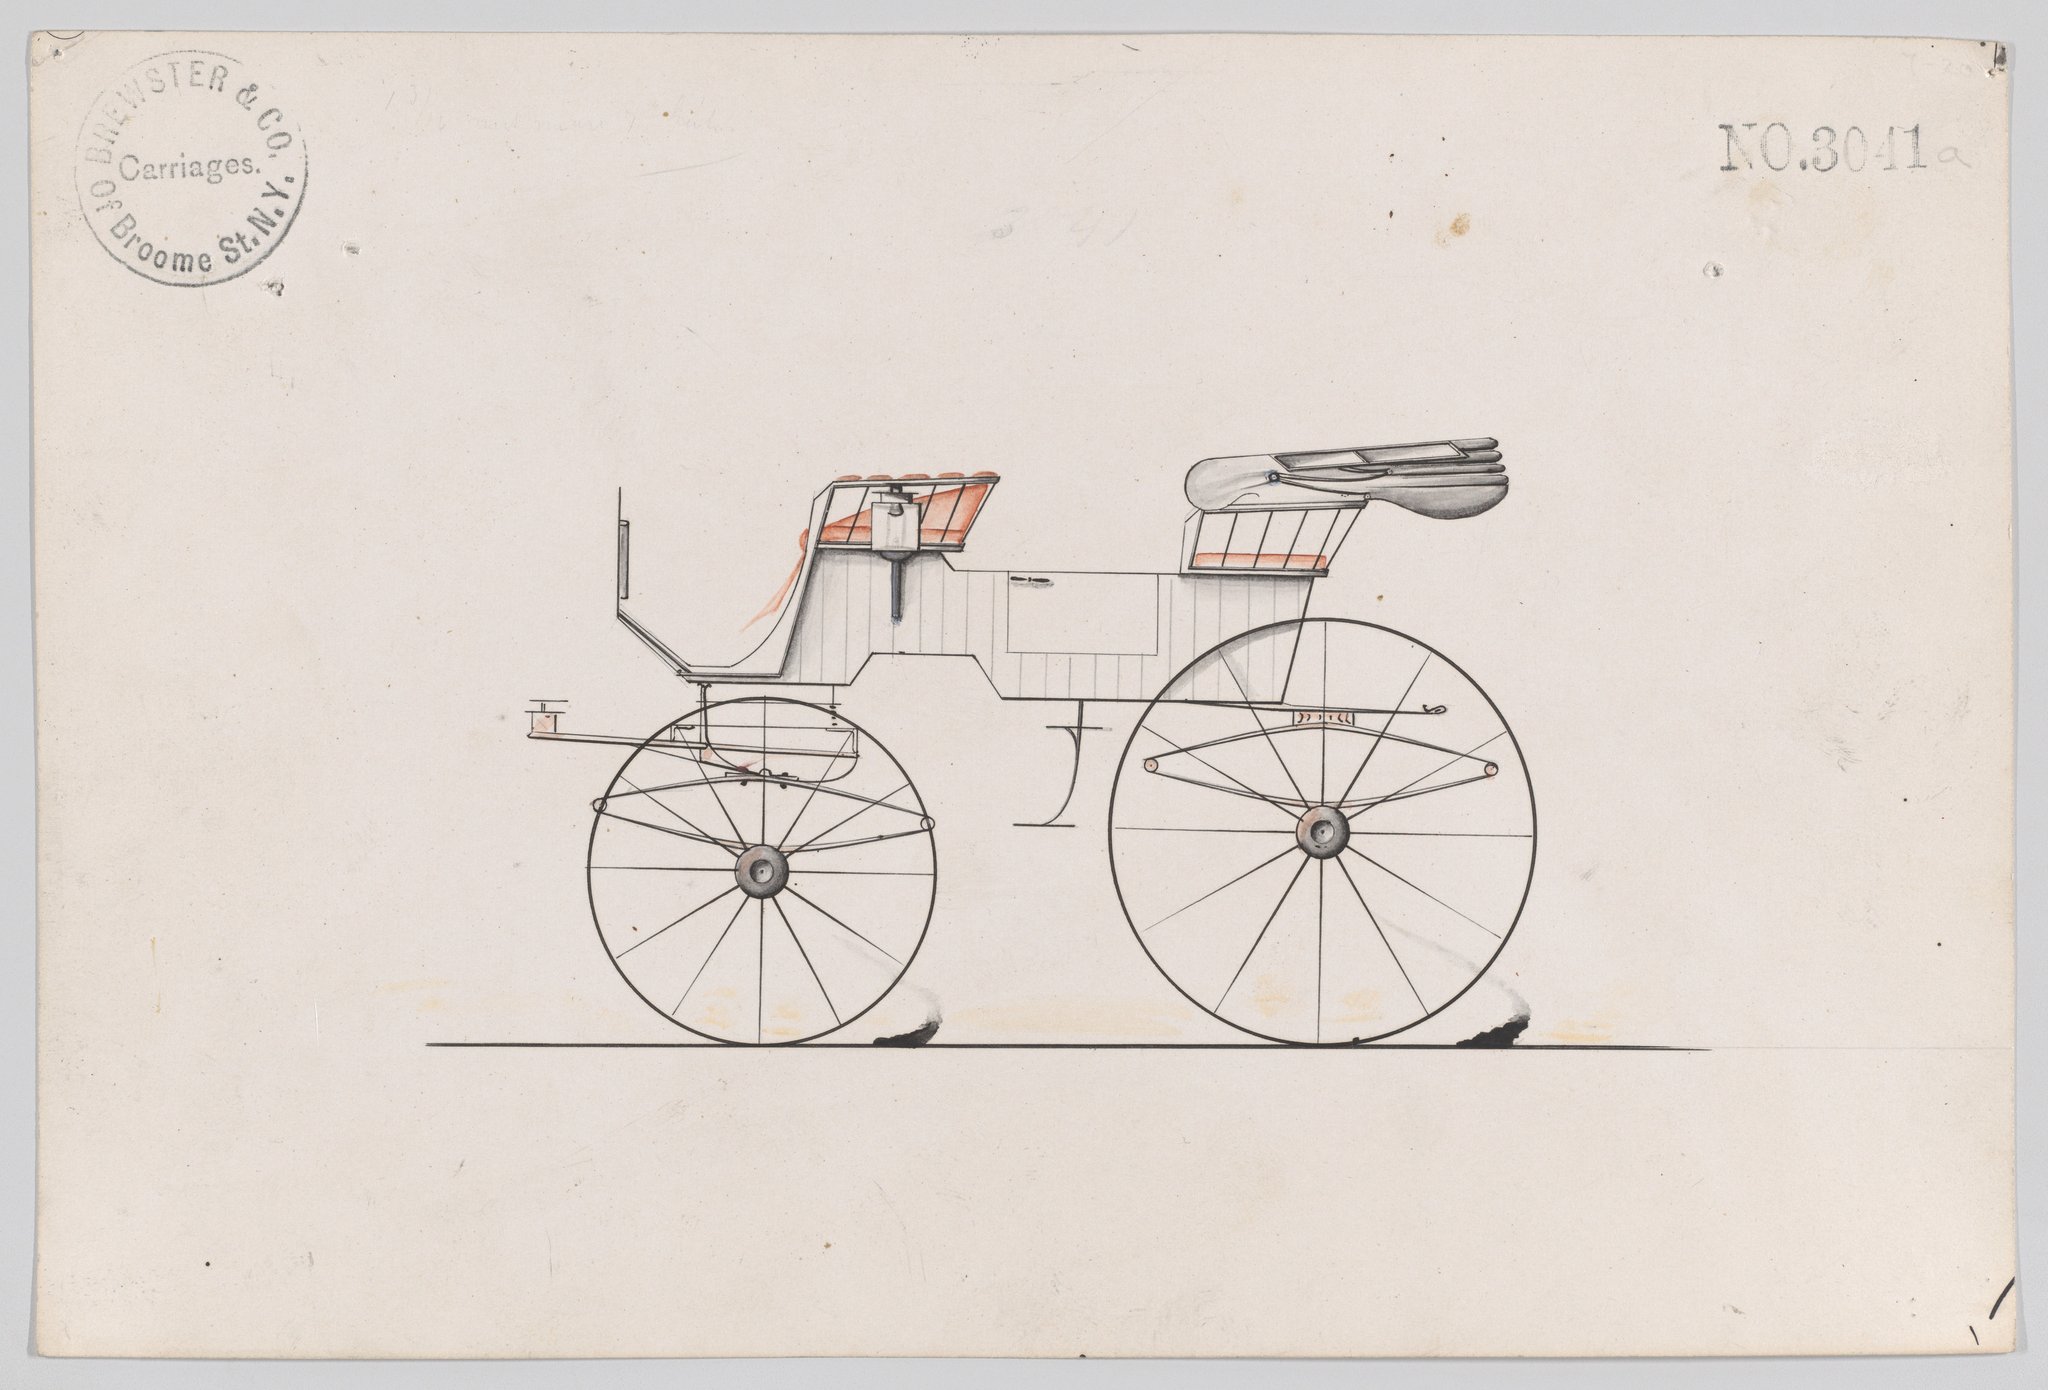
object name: drawing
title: Design for 2 seat Phaeton, no. 3041a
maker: brewster & co.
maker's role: manufacturer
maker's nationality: american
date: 1874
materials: gouache, ink, watercolor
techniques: pen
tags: carriages